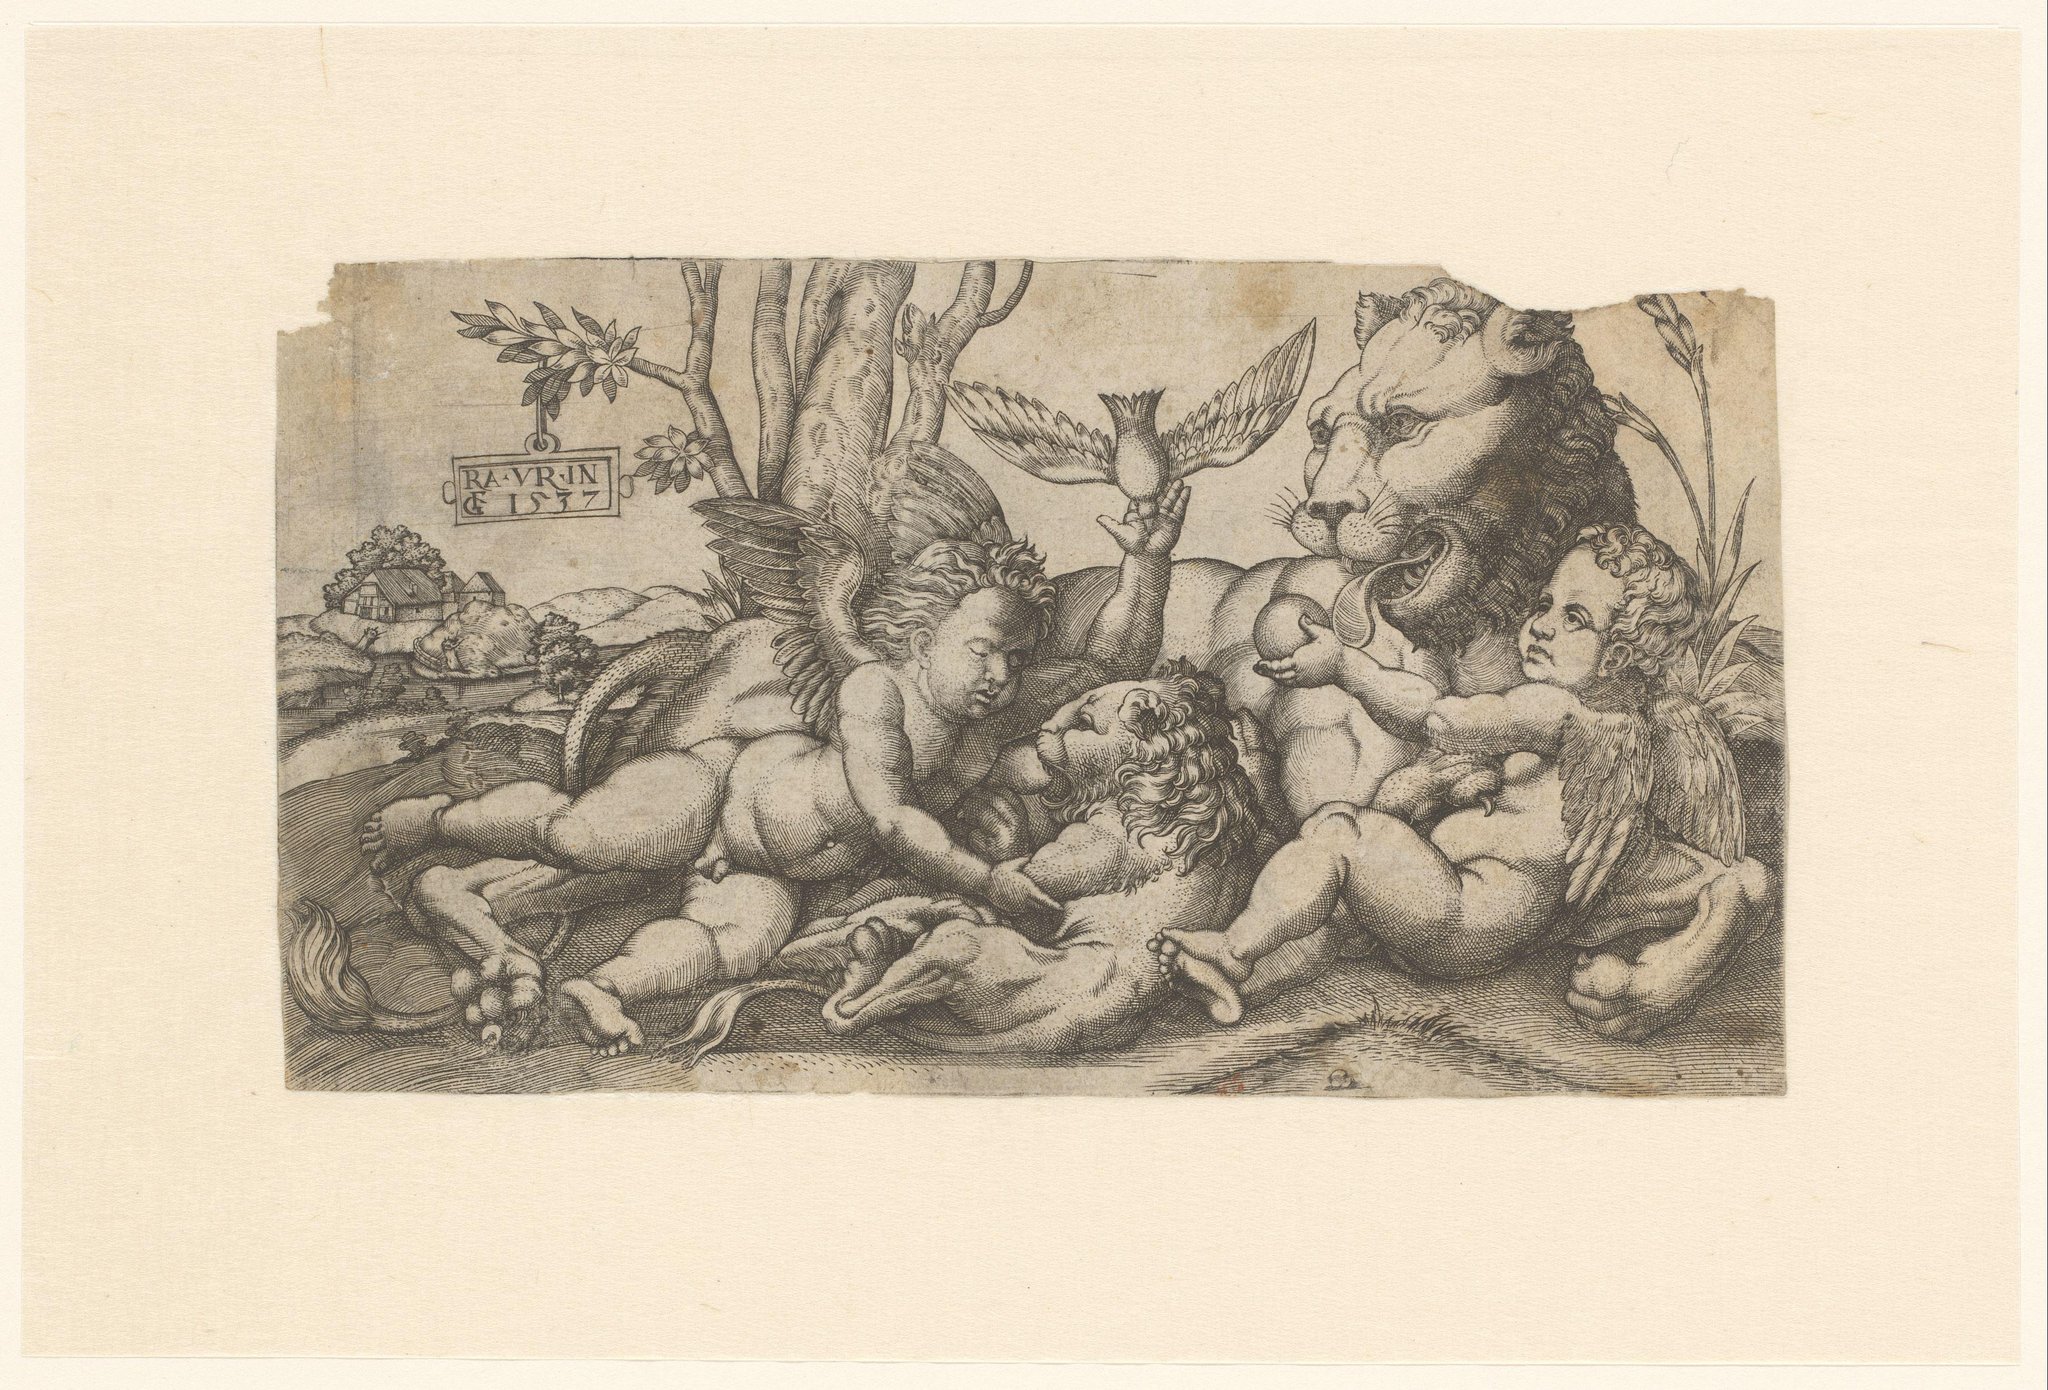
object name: print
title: Leeuw met welp en twee putti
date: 1537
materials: paper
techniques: engraving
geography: italy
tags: beasts of prey, predatory animals: lion, cupids: 'amores', 'amoretti', 'putti'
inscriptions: collector's mark: Lugt 2028